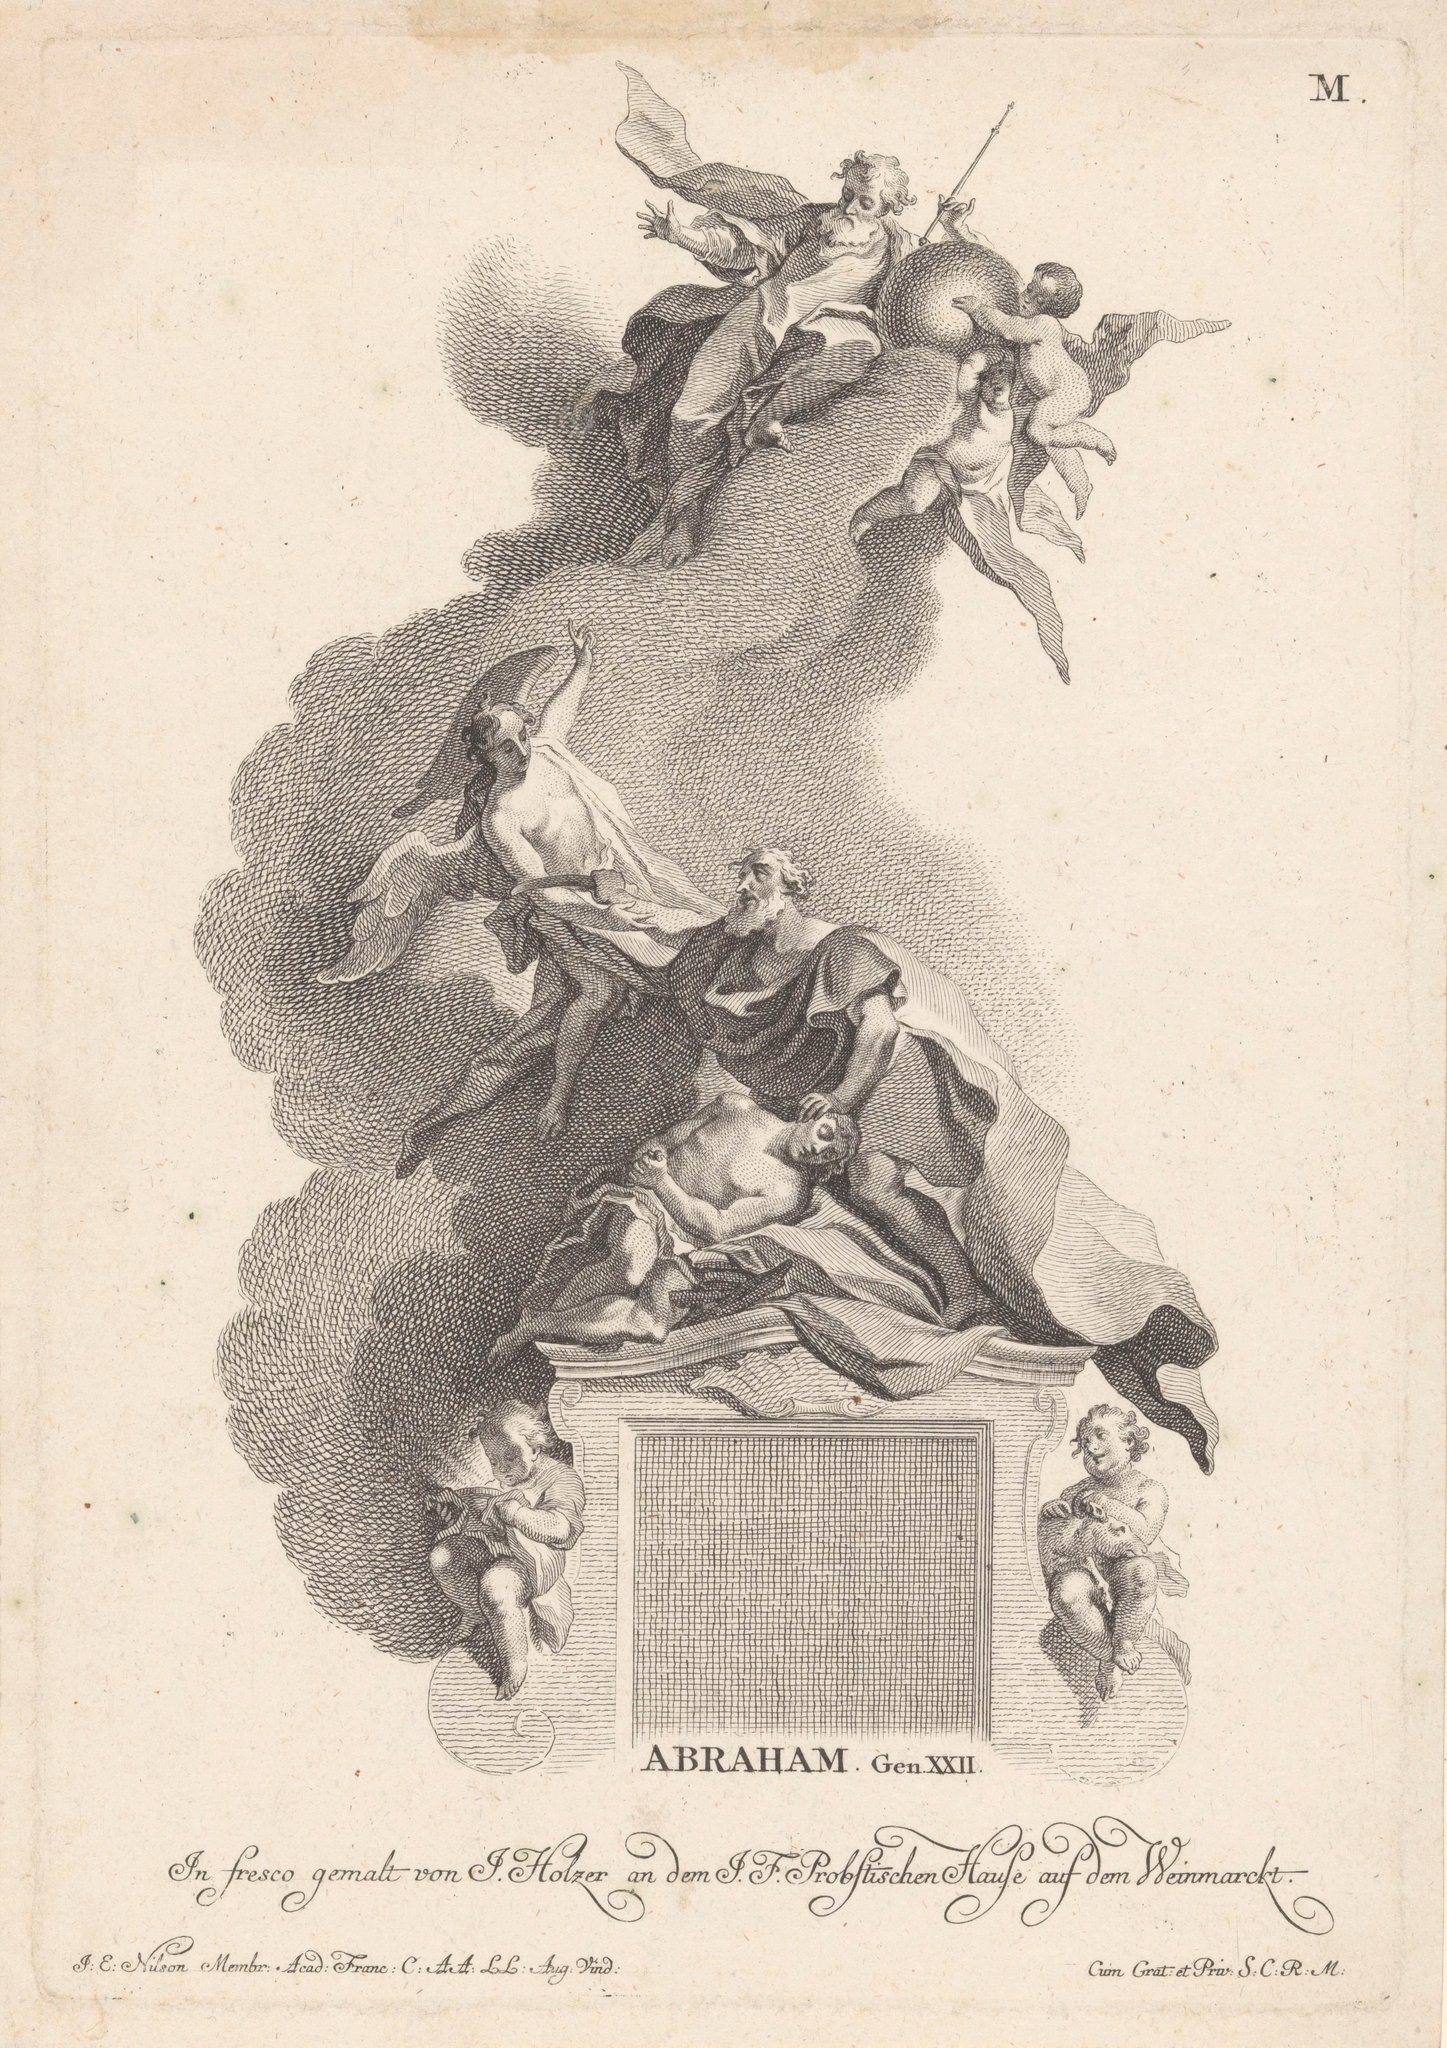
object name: print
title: Beproeving van Abraham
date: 1765-1770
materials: paper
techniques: engraving, etching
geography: augsburg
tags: god the father, when abraham has his hand raised to kill isaac, an angel restrains abraham's hand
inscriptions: collector's mark: Lugt 2760, collector's mark: Lugt 2228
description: De beproeving van Abraham. Abraham staat op het punt zijn zoon Isaak te offeren, maar een engel trekt zijn hand terug en wijst naar boven. Daar verschijnen God de Vader en twee putti op wolken. Onder zitten twee putti met een offerlam en offervuur.